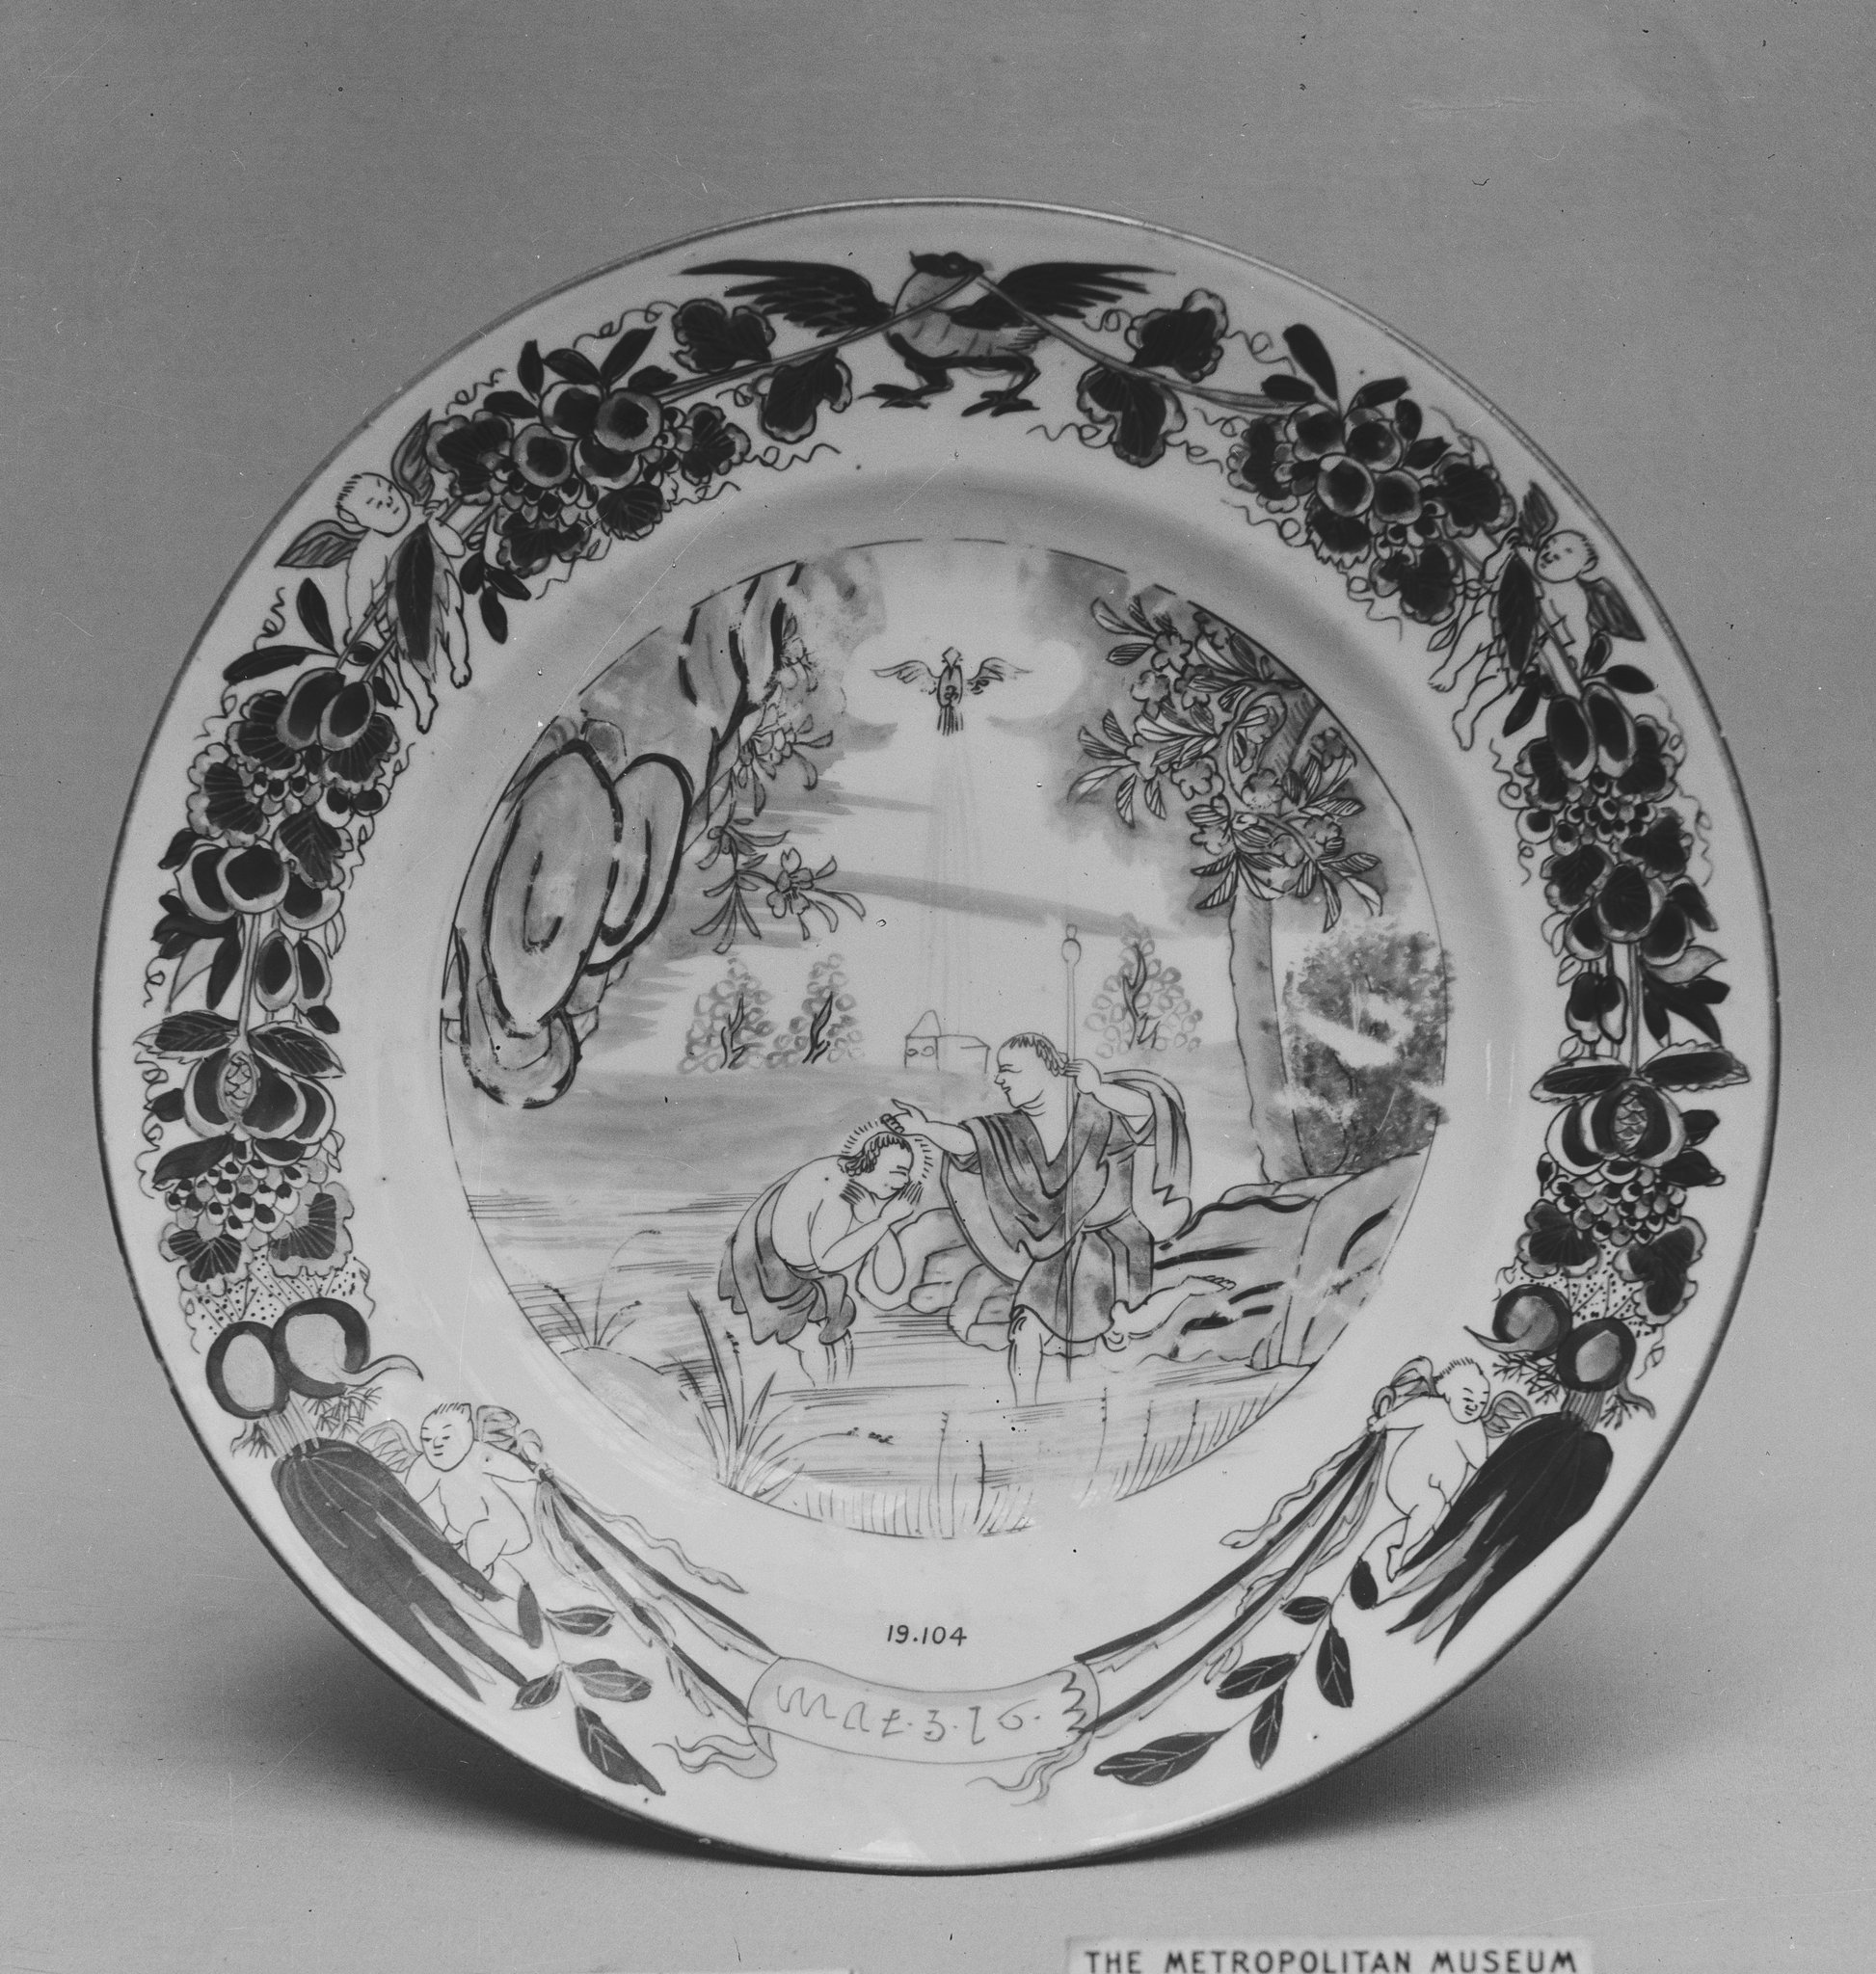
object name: plate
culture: chinese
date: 1662-1722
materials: porcelain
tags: birds,trees,angels